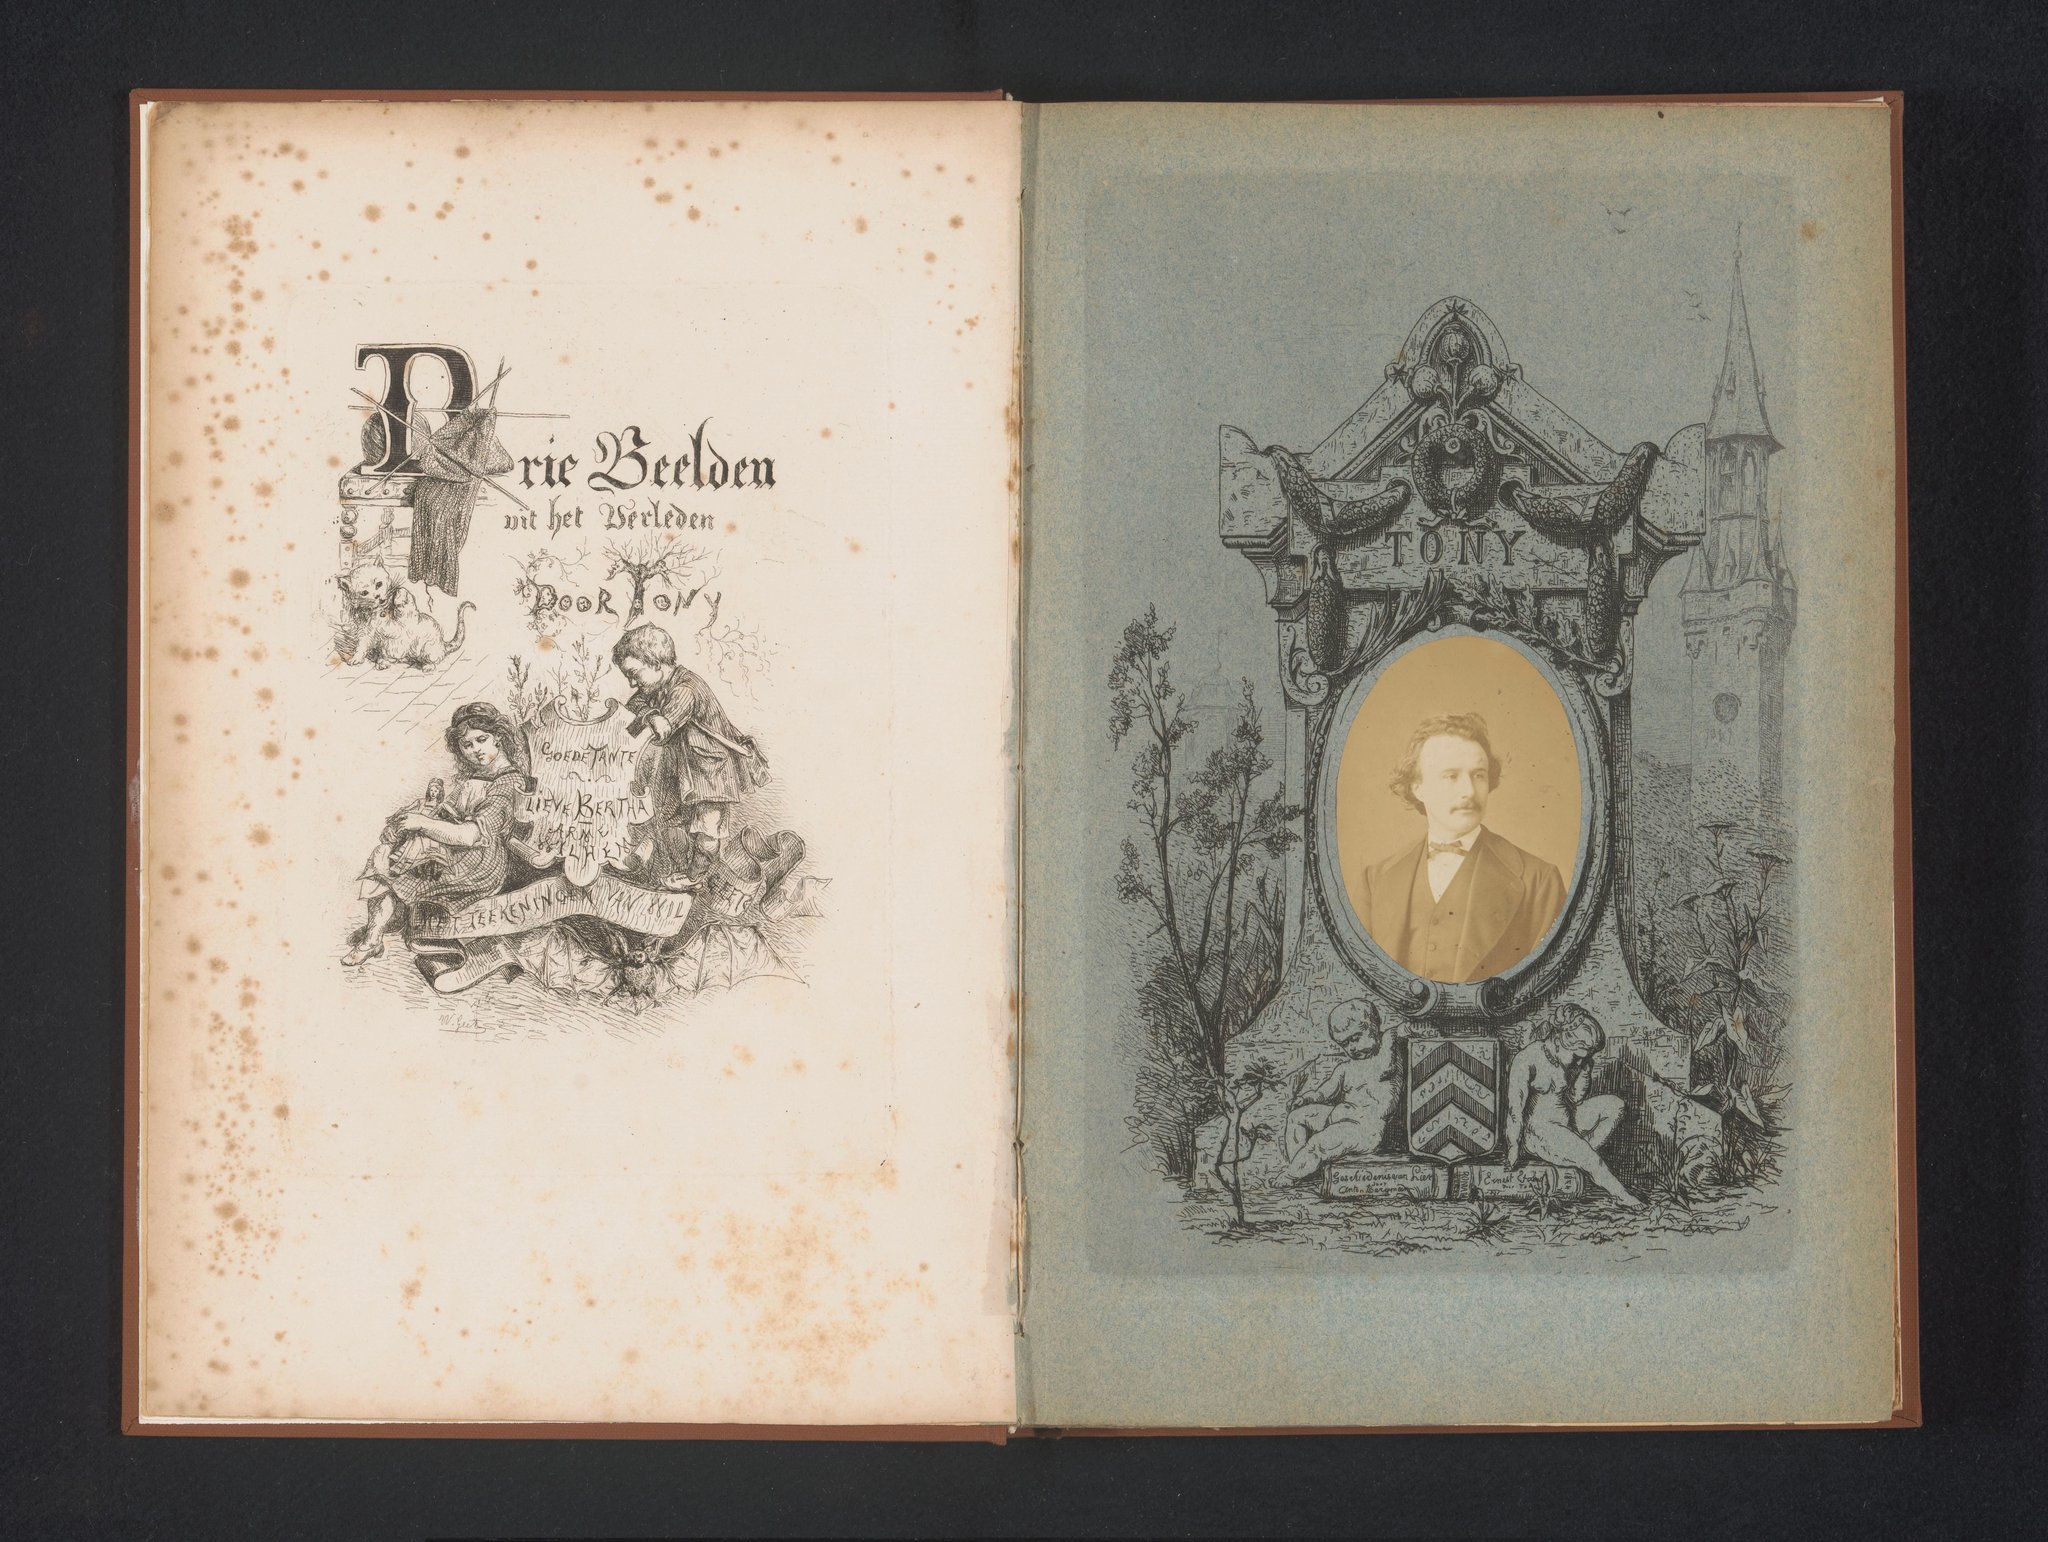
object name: photograph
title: Portret van Anton Bergmann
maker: Anonymous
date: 1869-1874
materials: photographic support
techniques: albumen print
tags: lierre, anton bergmann, historical persons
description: Foto op tweede ongenummerde pagina voor titelpagina.